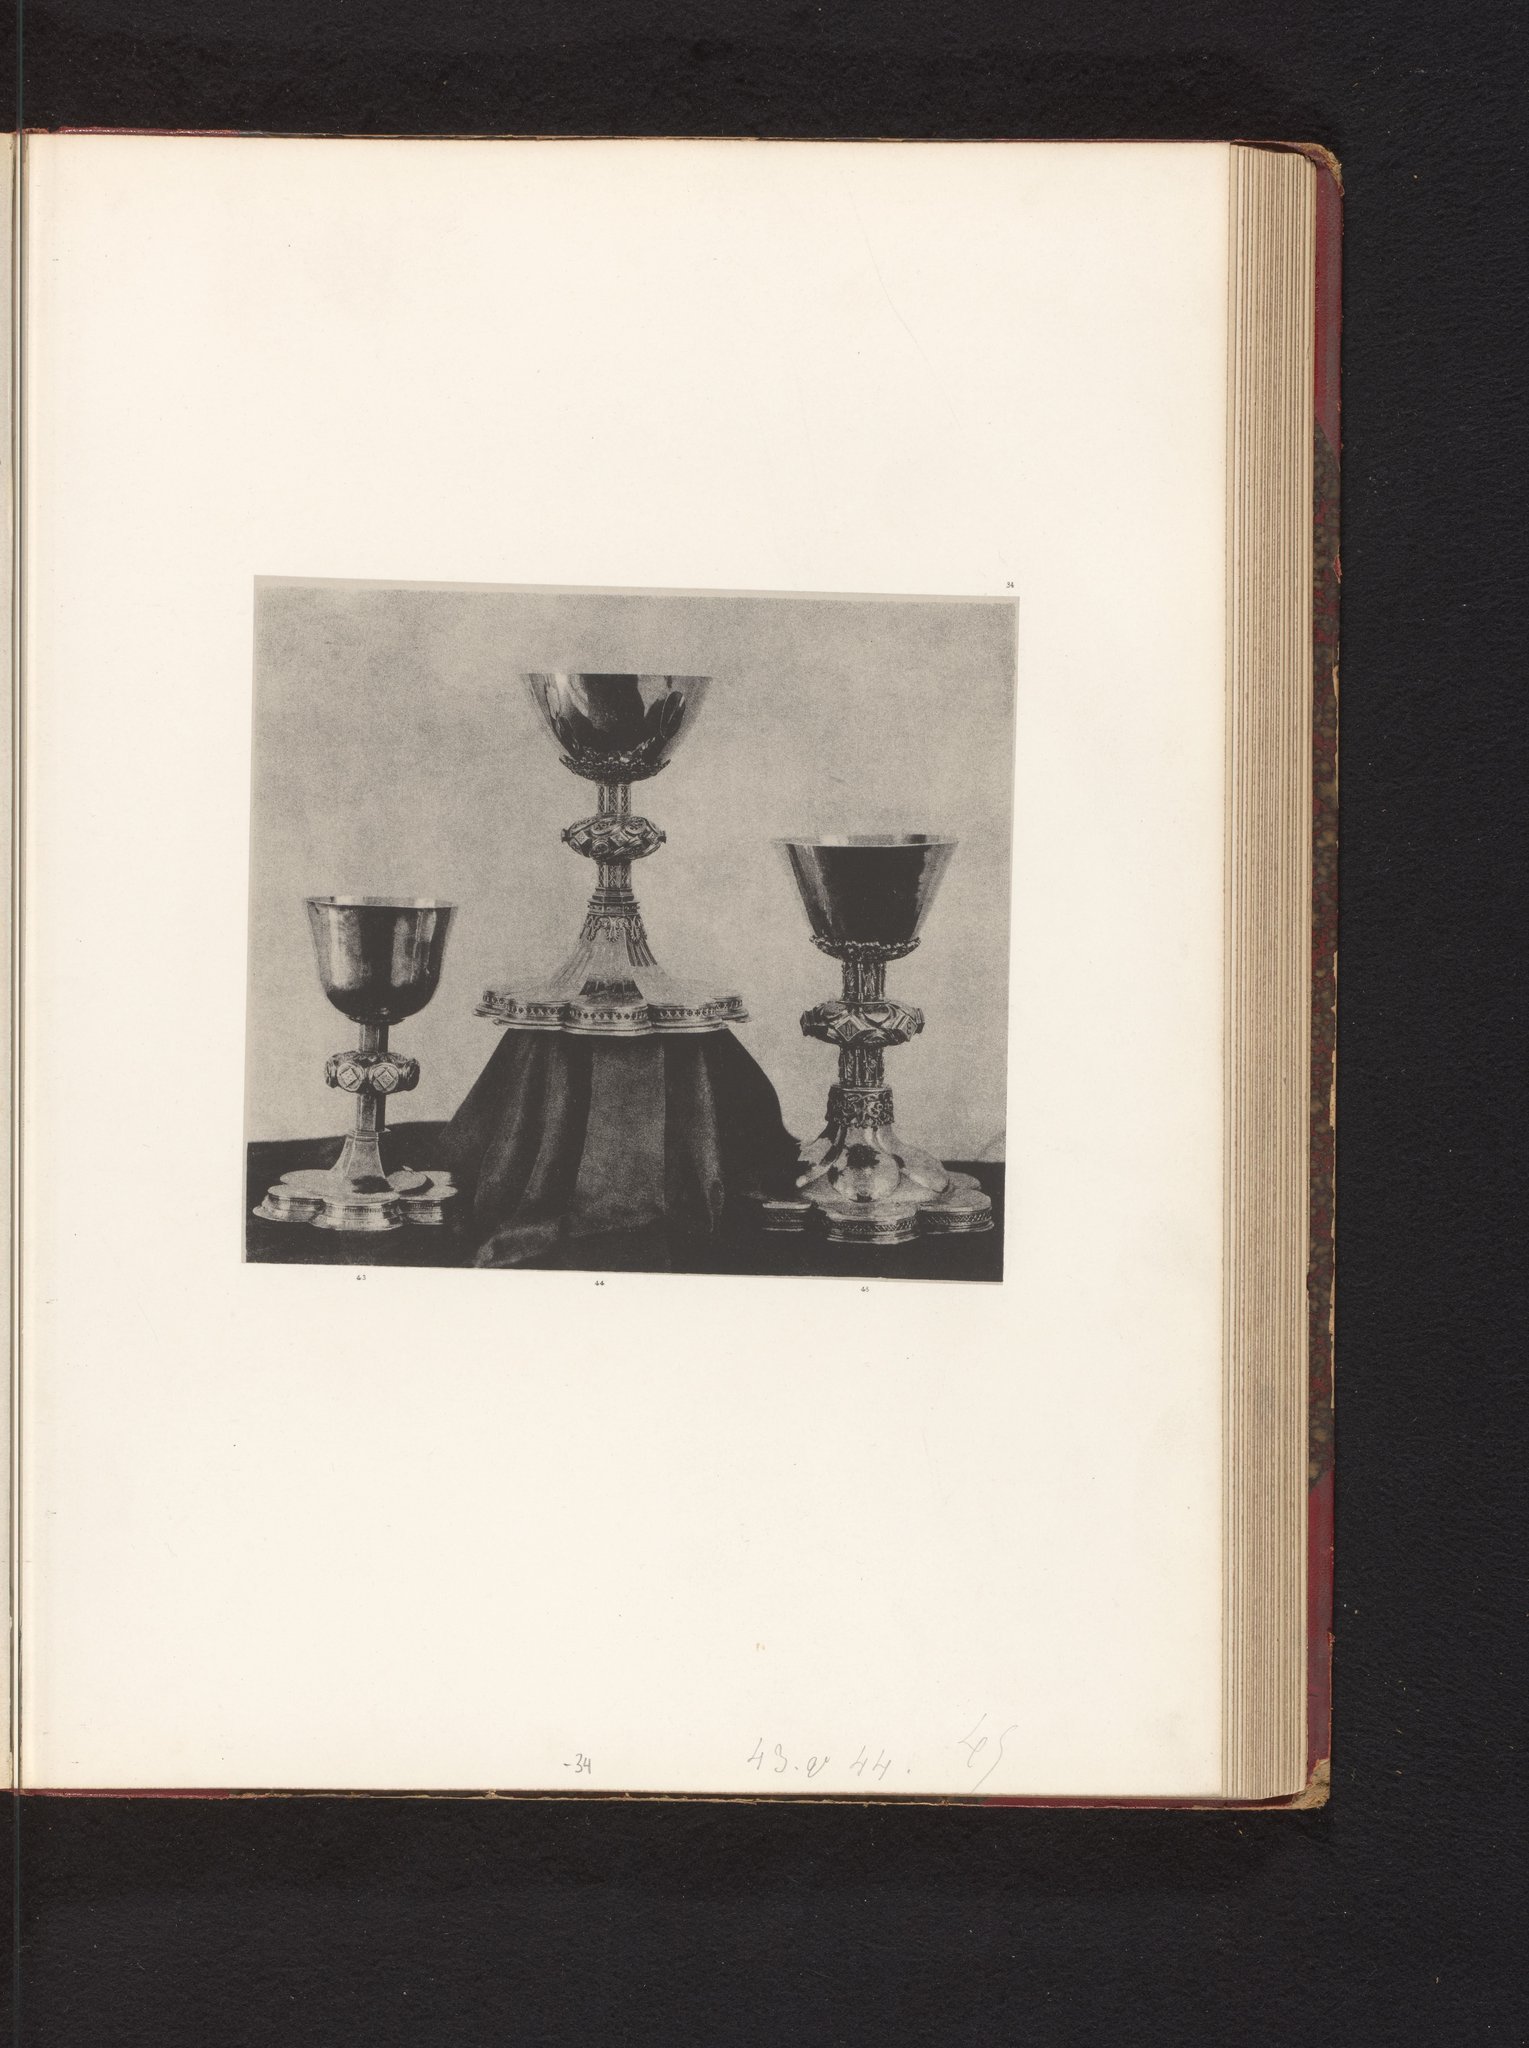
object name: page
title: Drie vergulde kelken, opgesteld op een tentoonstelling over religieuze objecten uit de middeleeuwen en renaissance in 1864 in Mechelen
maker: joseph maes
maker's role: fotograaf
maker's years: 1838-1908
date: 1864-1866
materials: paper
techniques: photolithography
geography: mechelen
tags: chalice, mechelen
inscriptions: number: ‘43 - 44 - 45’, number: ‘-34’, number: ‘43 [.] 44. 45’